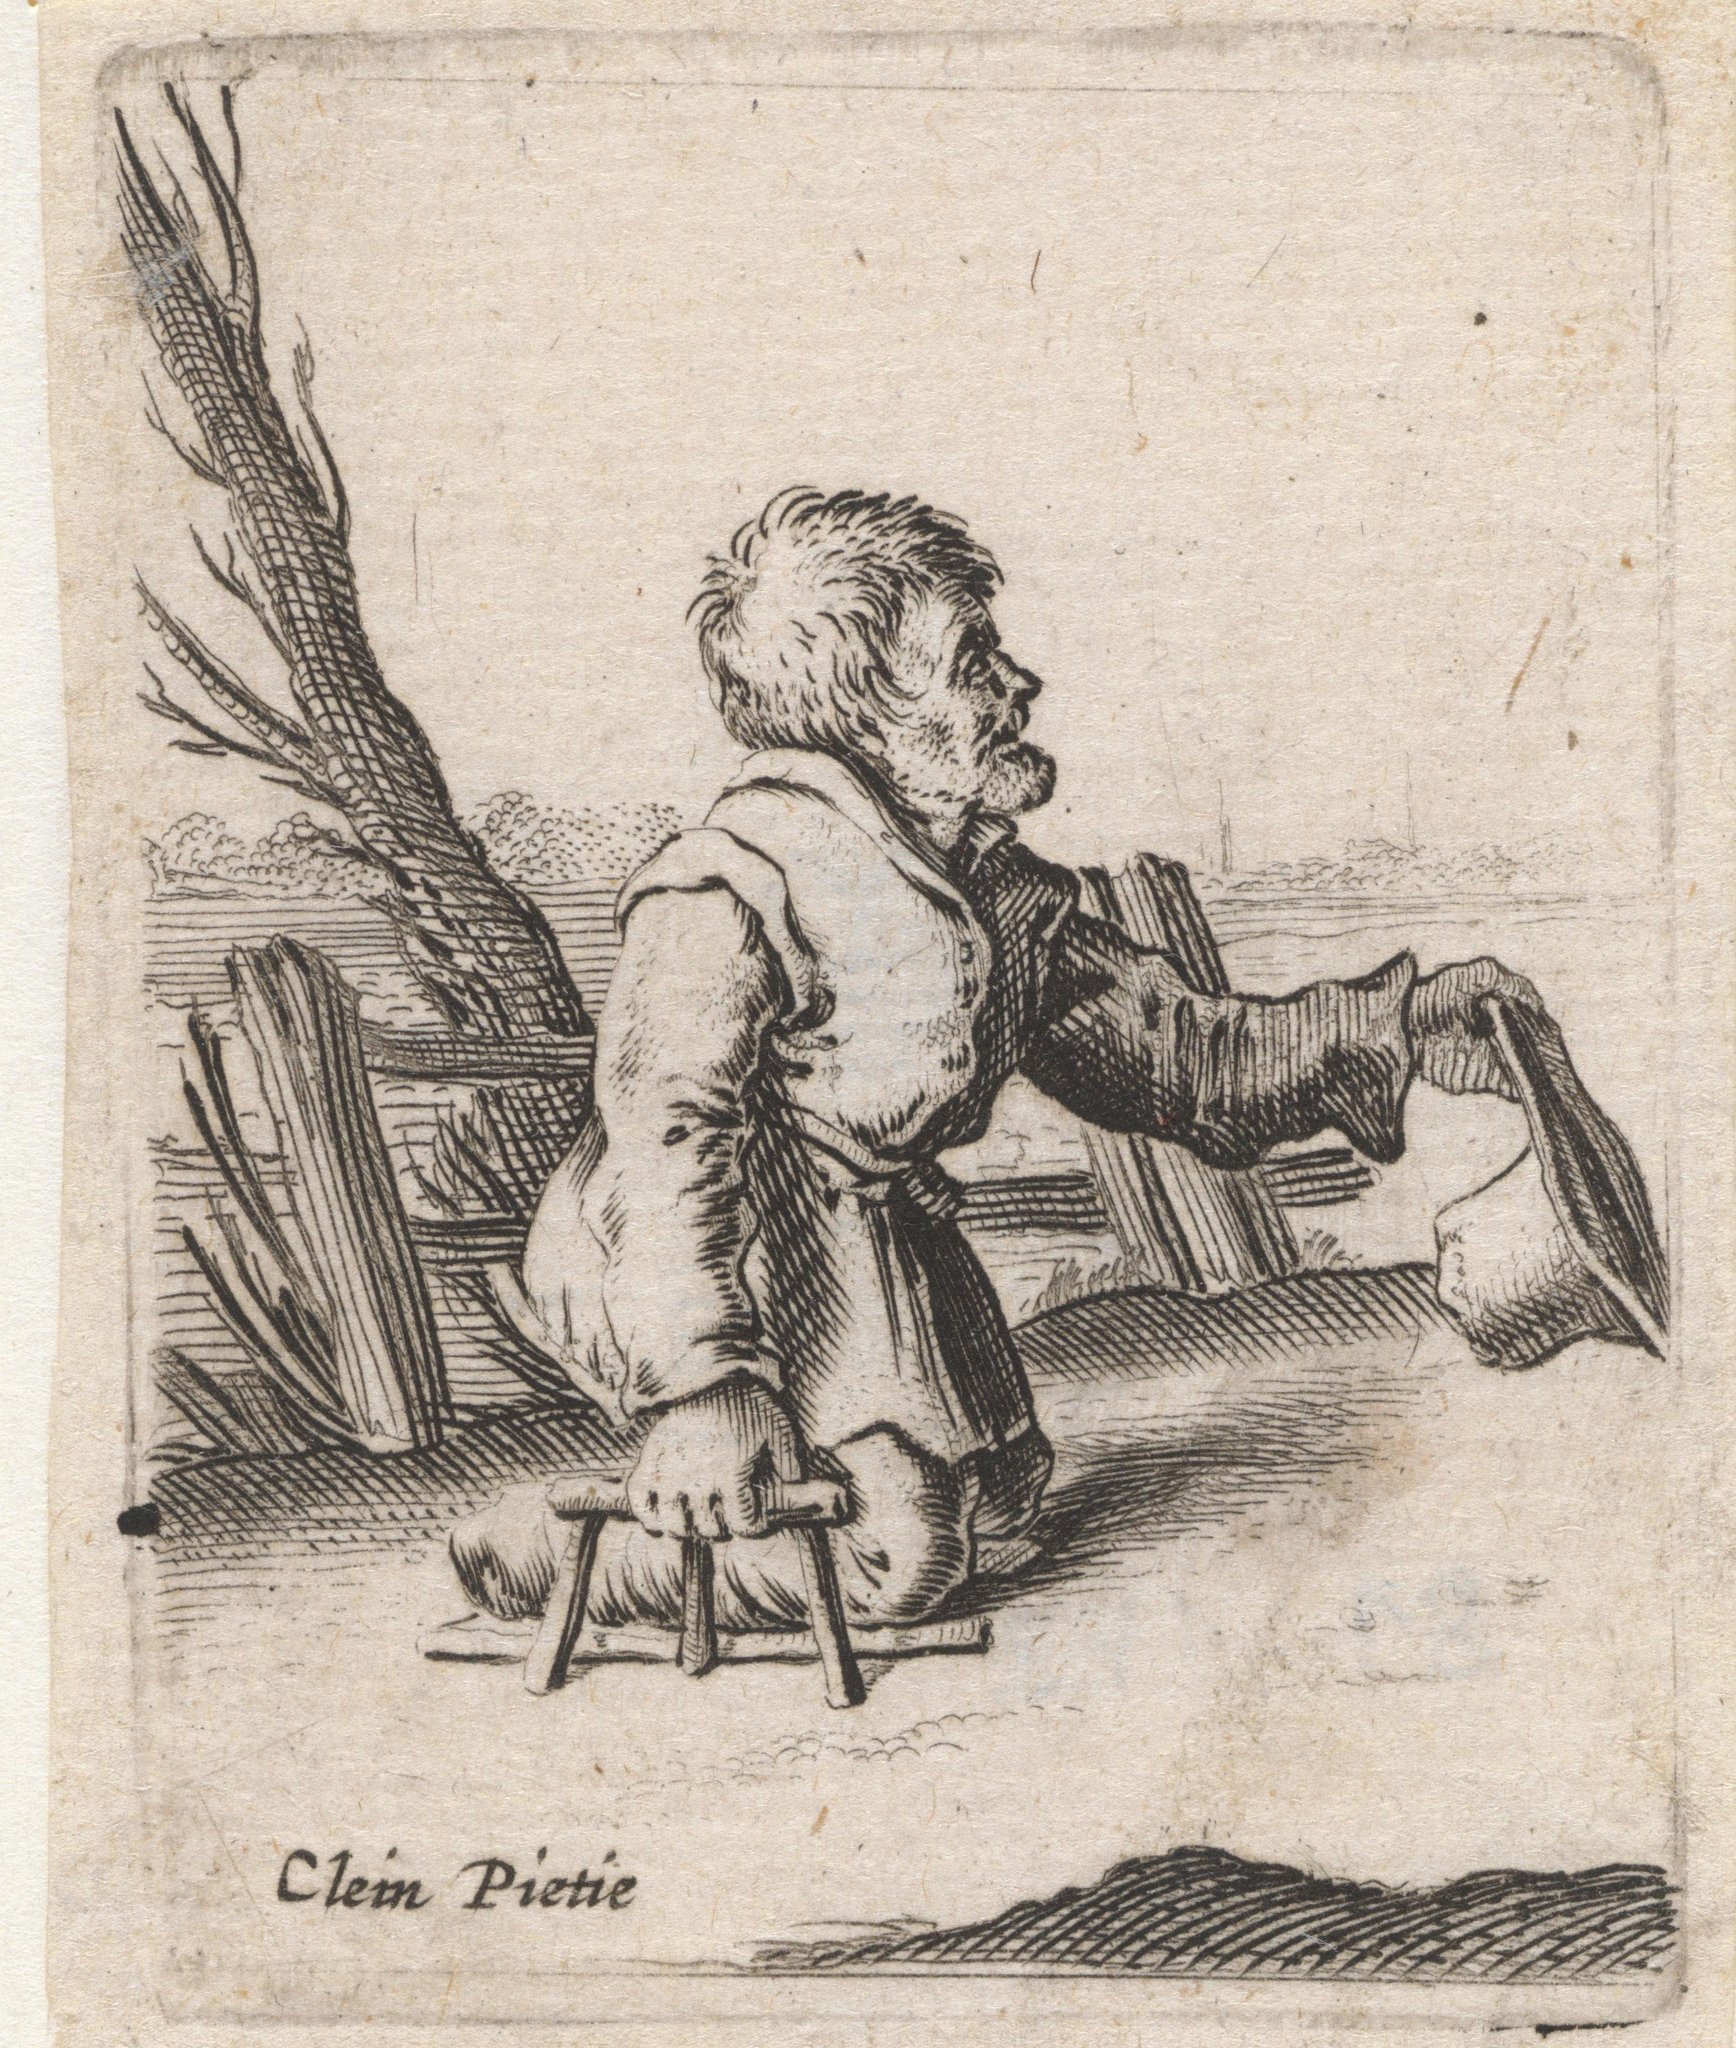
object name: print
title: Bedelende man op handkrukken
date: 1638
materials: paper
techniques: engraving, etching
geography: netherlands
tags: person with a physical disability, beggar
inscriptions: collector's mark: Lugt 2760, collector's mark: Lugt 2228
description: Een man steunt op zijn krukken en bedelt met zijn hoed. Op de achtergrond een hek en een boom. De prent maakt deel uit van een serie van 32 prenten met genretaferelen. In de tijd waarin deze prent ontstond was 'kreupel' een generiek woord om een lichamelijke beperking aan het onderlichaam te beschrijven.